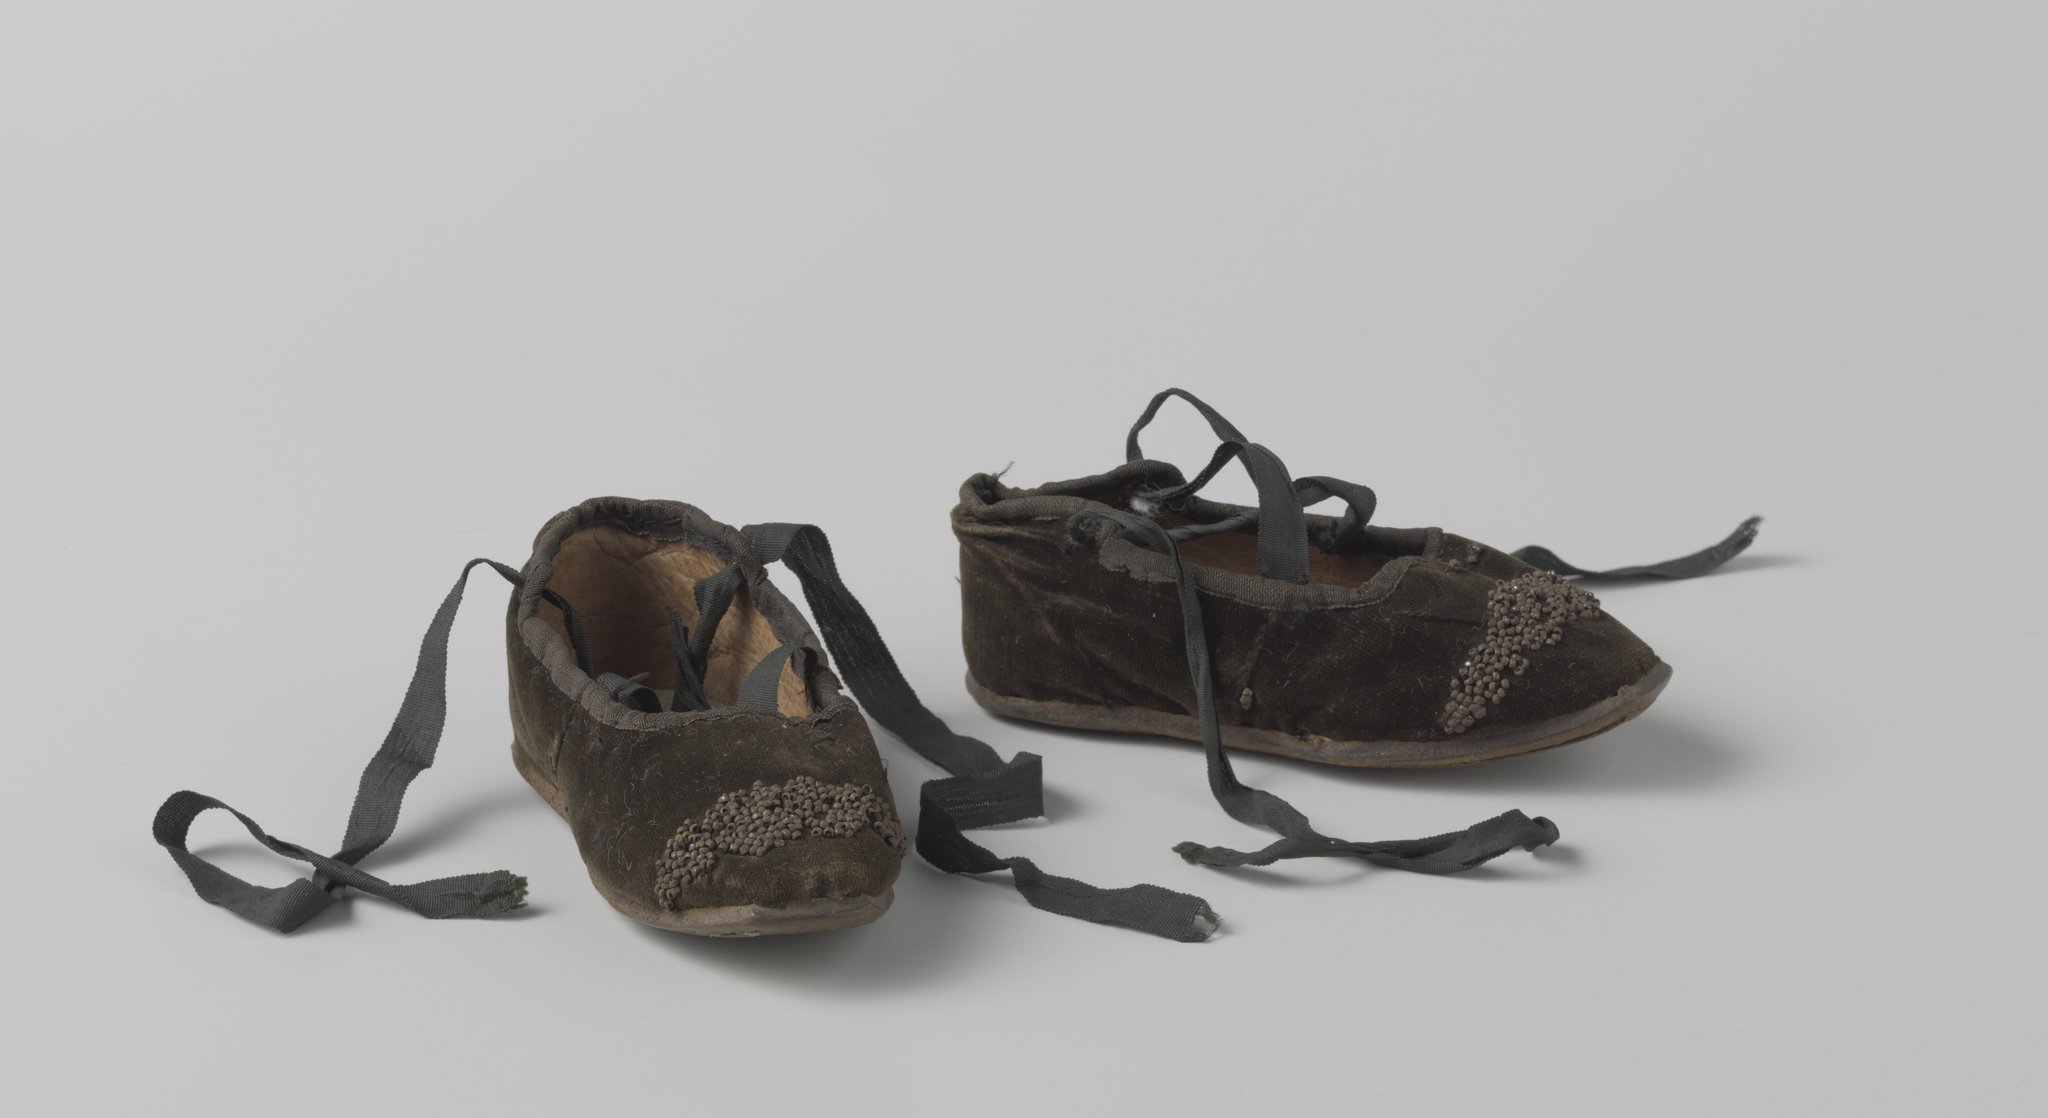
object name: shoe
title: Schoen van zwart fluweel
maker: Anonymous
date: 1800-1850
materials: cotton, leather, velvet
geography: netherlands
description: Een paar zwart fluweel en kinderschoentjes met lederen zooltjes en met metalen kralen versierd. Einde der 18e of begin der 19e eeuw.